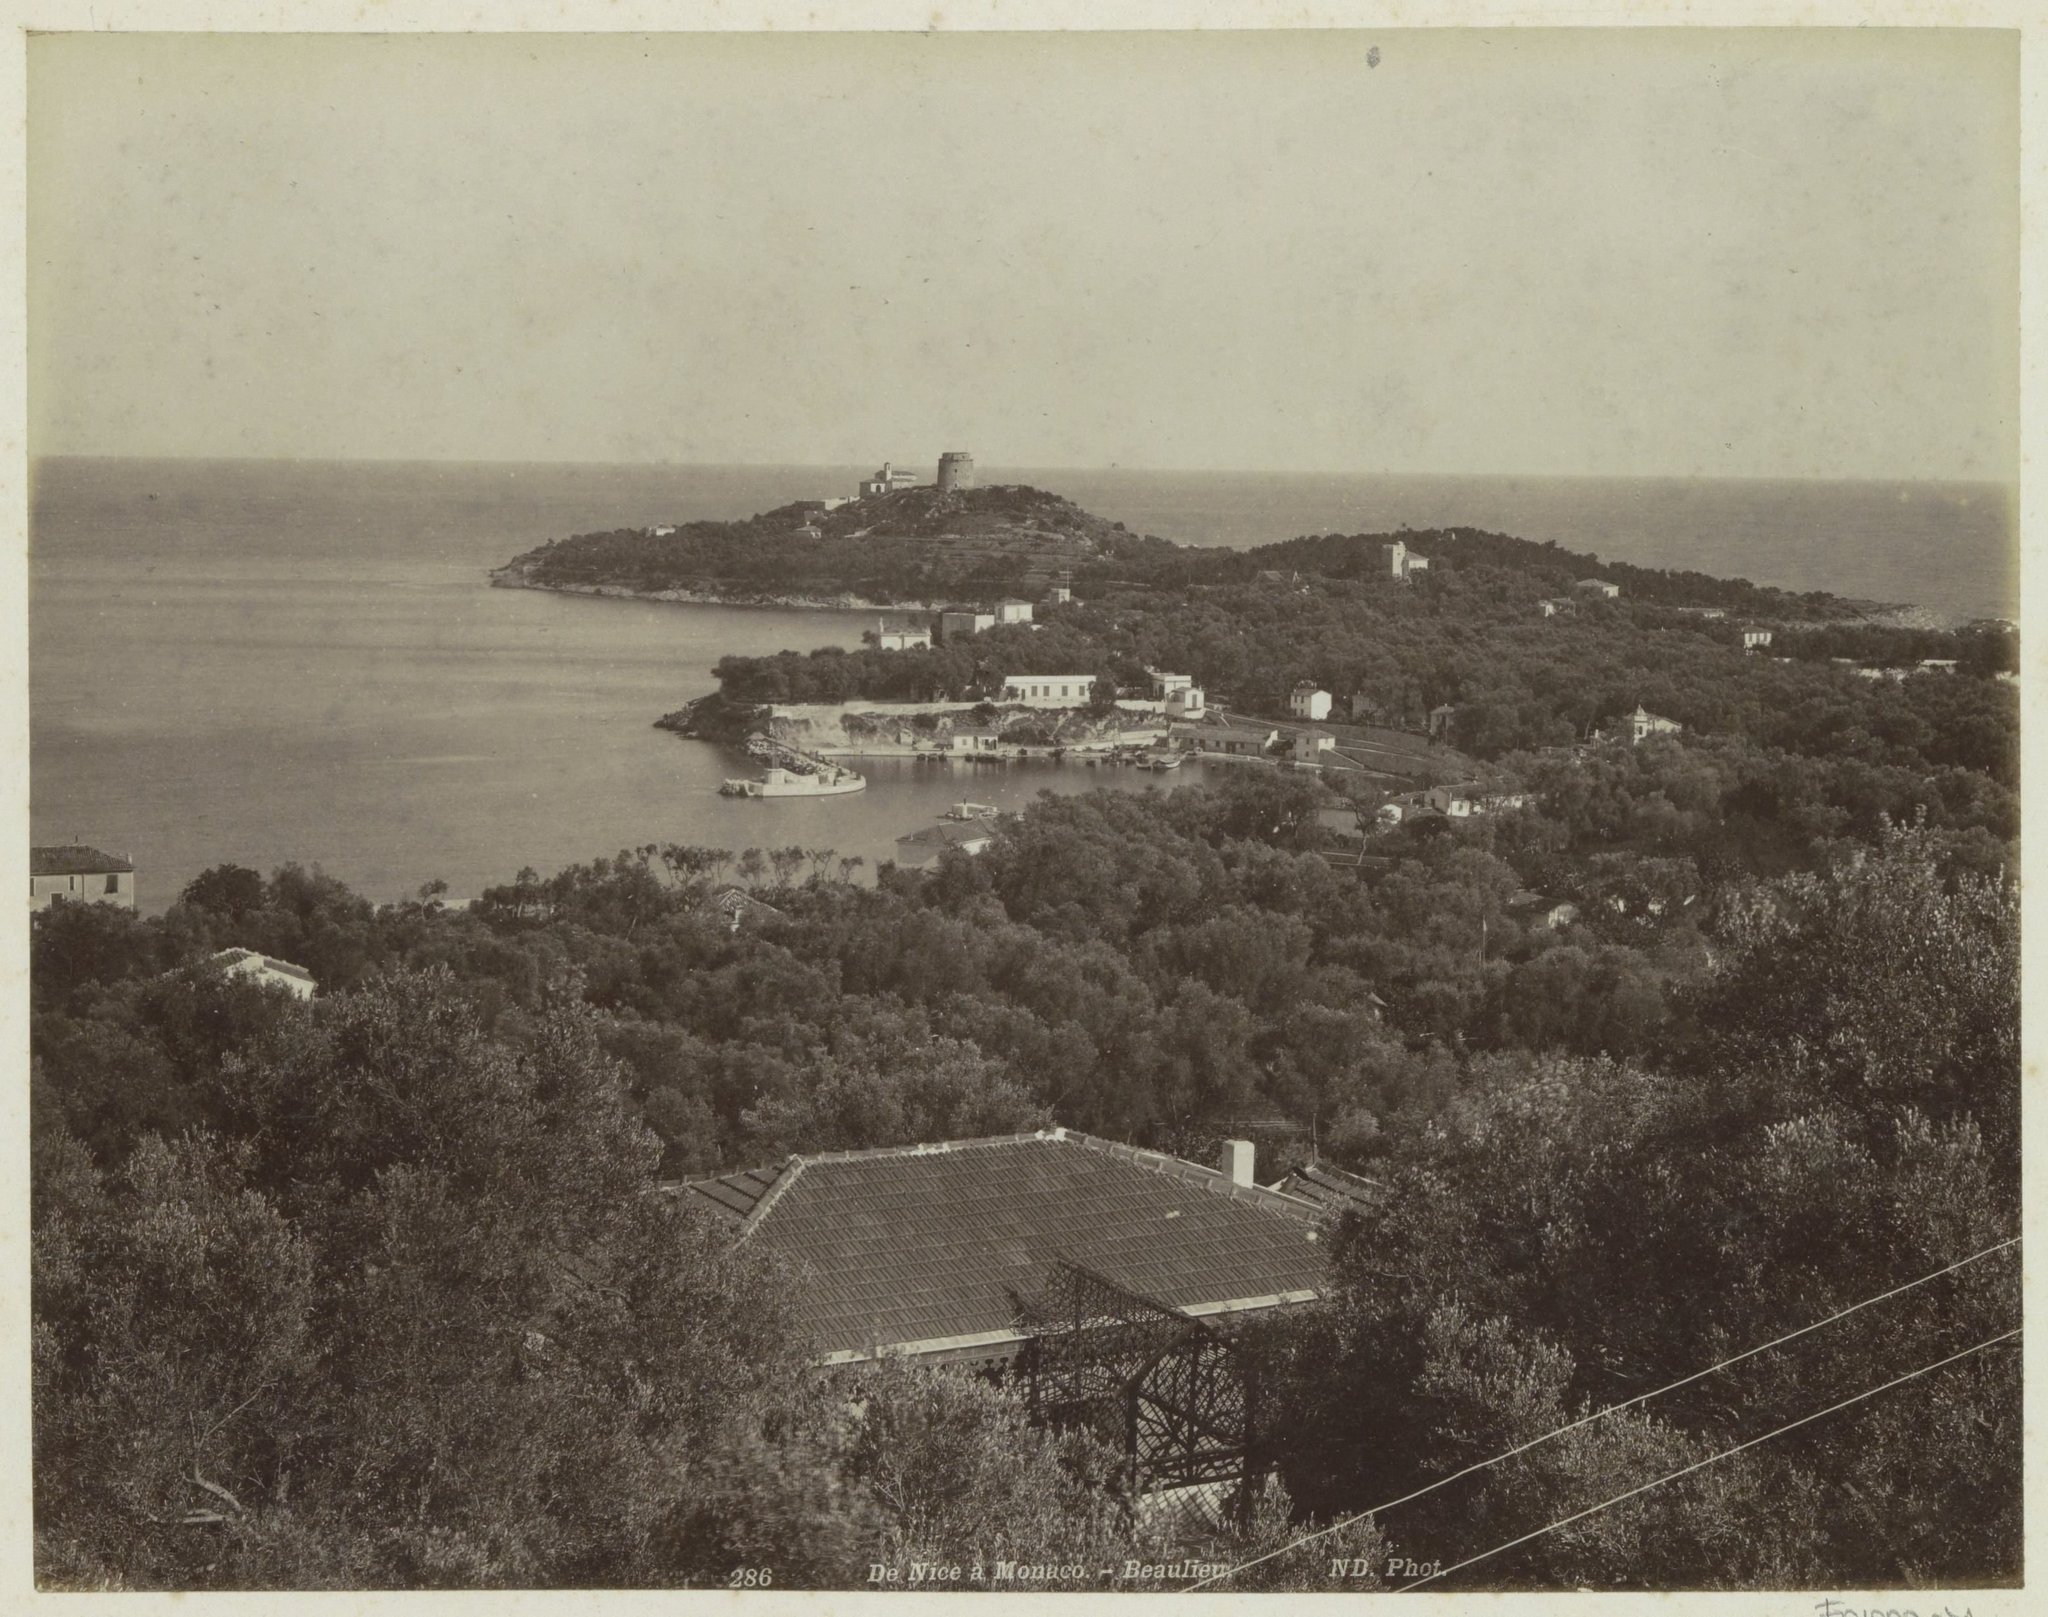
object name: photograph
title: De Nice à Monaco. - Beaulieu.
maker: étienne neurdein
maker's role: publisher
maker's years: 1832-1918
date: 1870-1900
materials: paper, photographic support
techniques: albumen print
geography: beaulieu-sur-mer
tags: prospect of village, silhouette of village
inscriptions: negative number: ‘286’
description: Onderdeel van Reisalbum met foto's van bezienswaardigheden in Italië en Frankrijk.